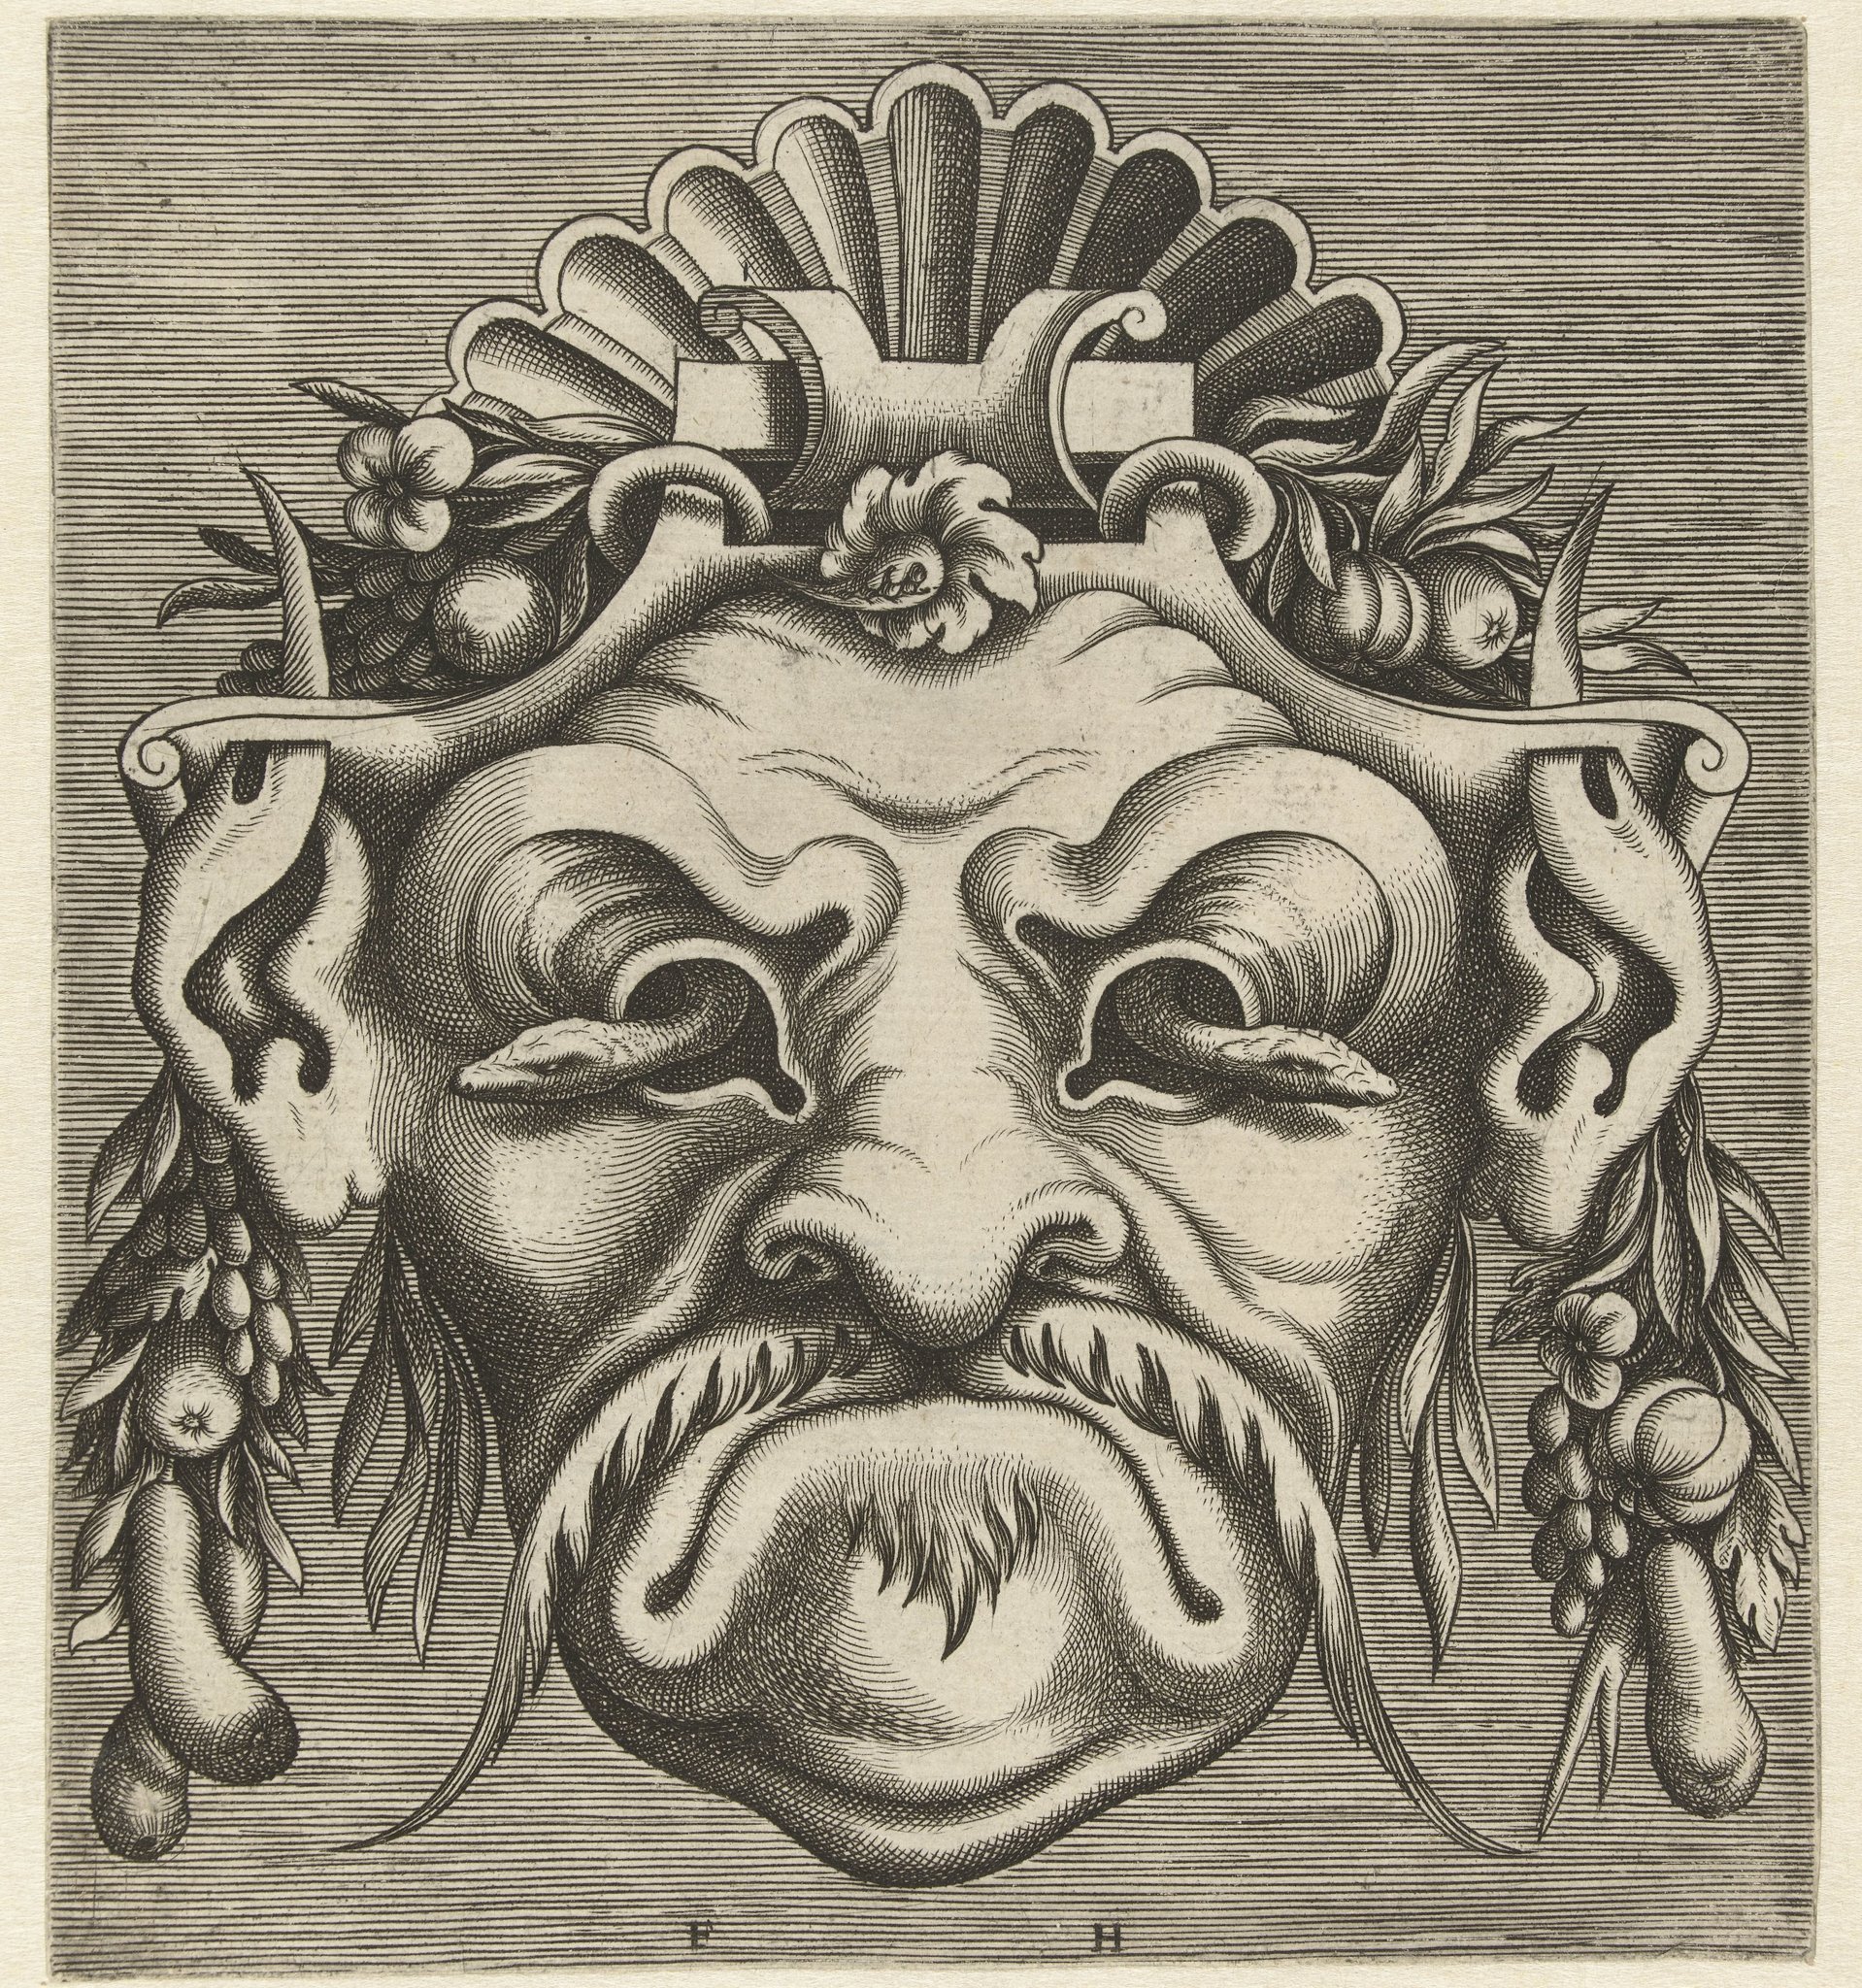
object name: ornament print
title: Pourtraicture ingenieuse de plusieurs facons de masques…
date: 1555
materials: paper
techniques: engraving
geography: antwerp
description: Het masker heeft een schelp op zijn hoofd en vruchtenguirlandes aan zijn oren. Een van 14 bladen uit een serie van 18 met als titel 'Pourtraicture ingenieuse de plusieurs façons de masques...'. Het titelblad ontbreekt.